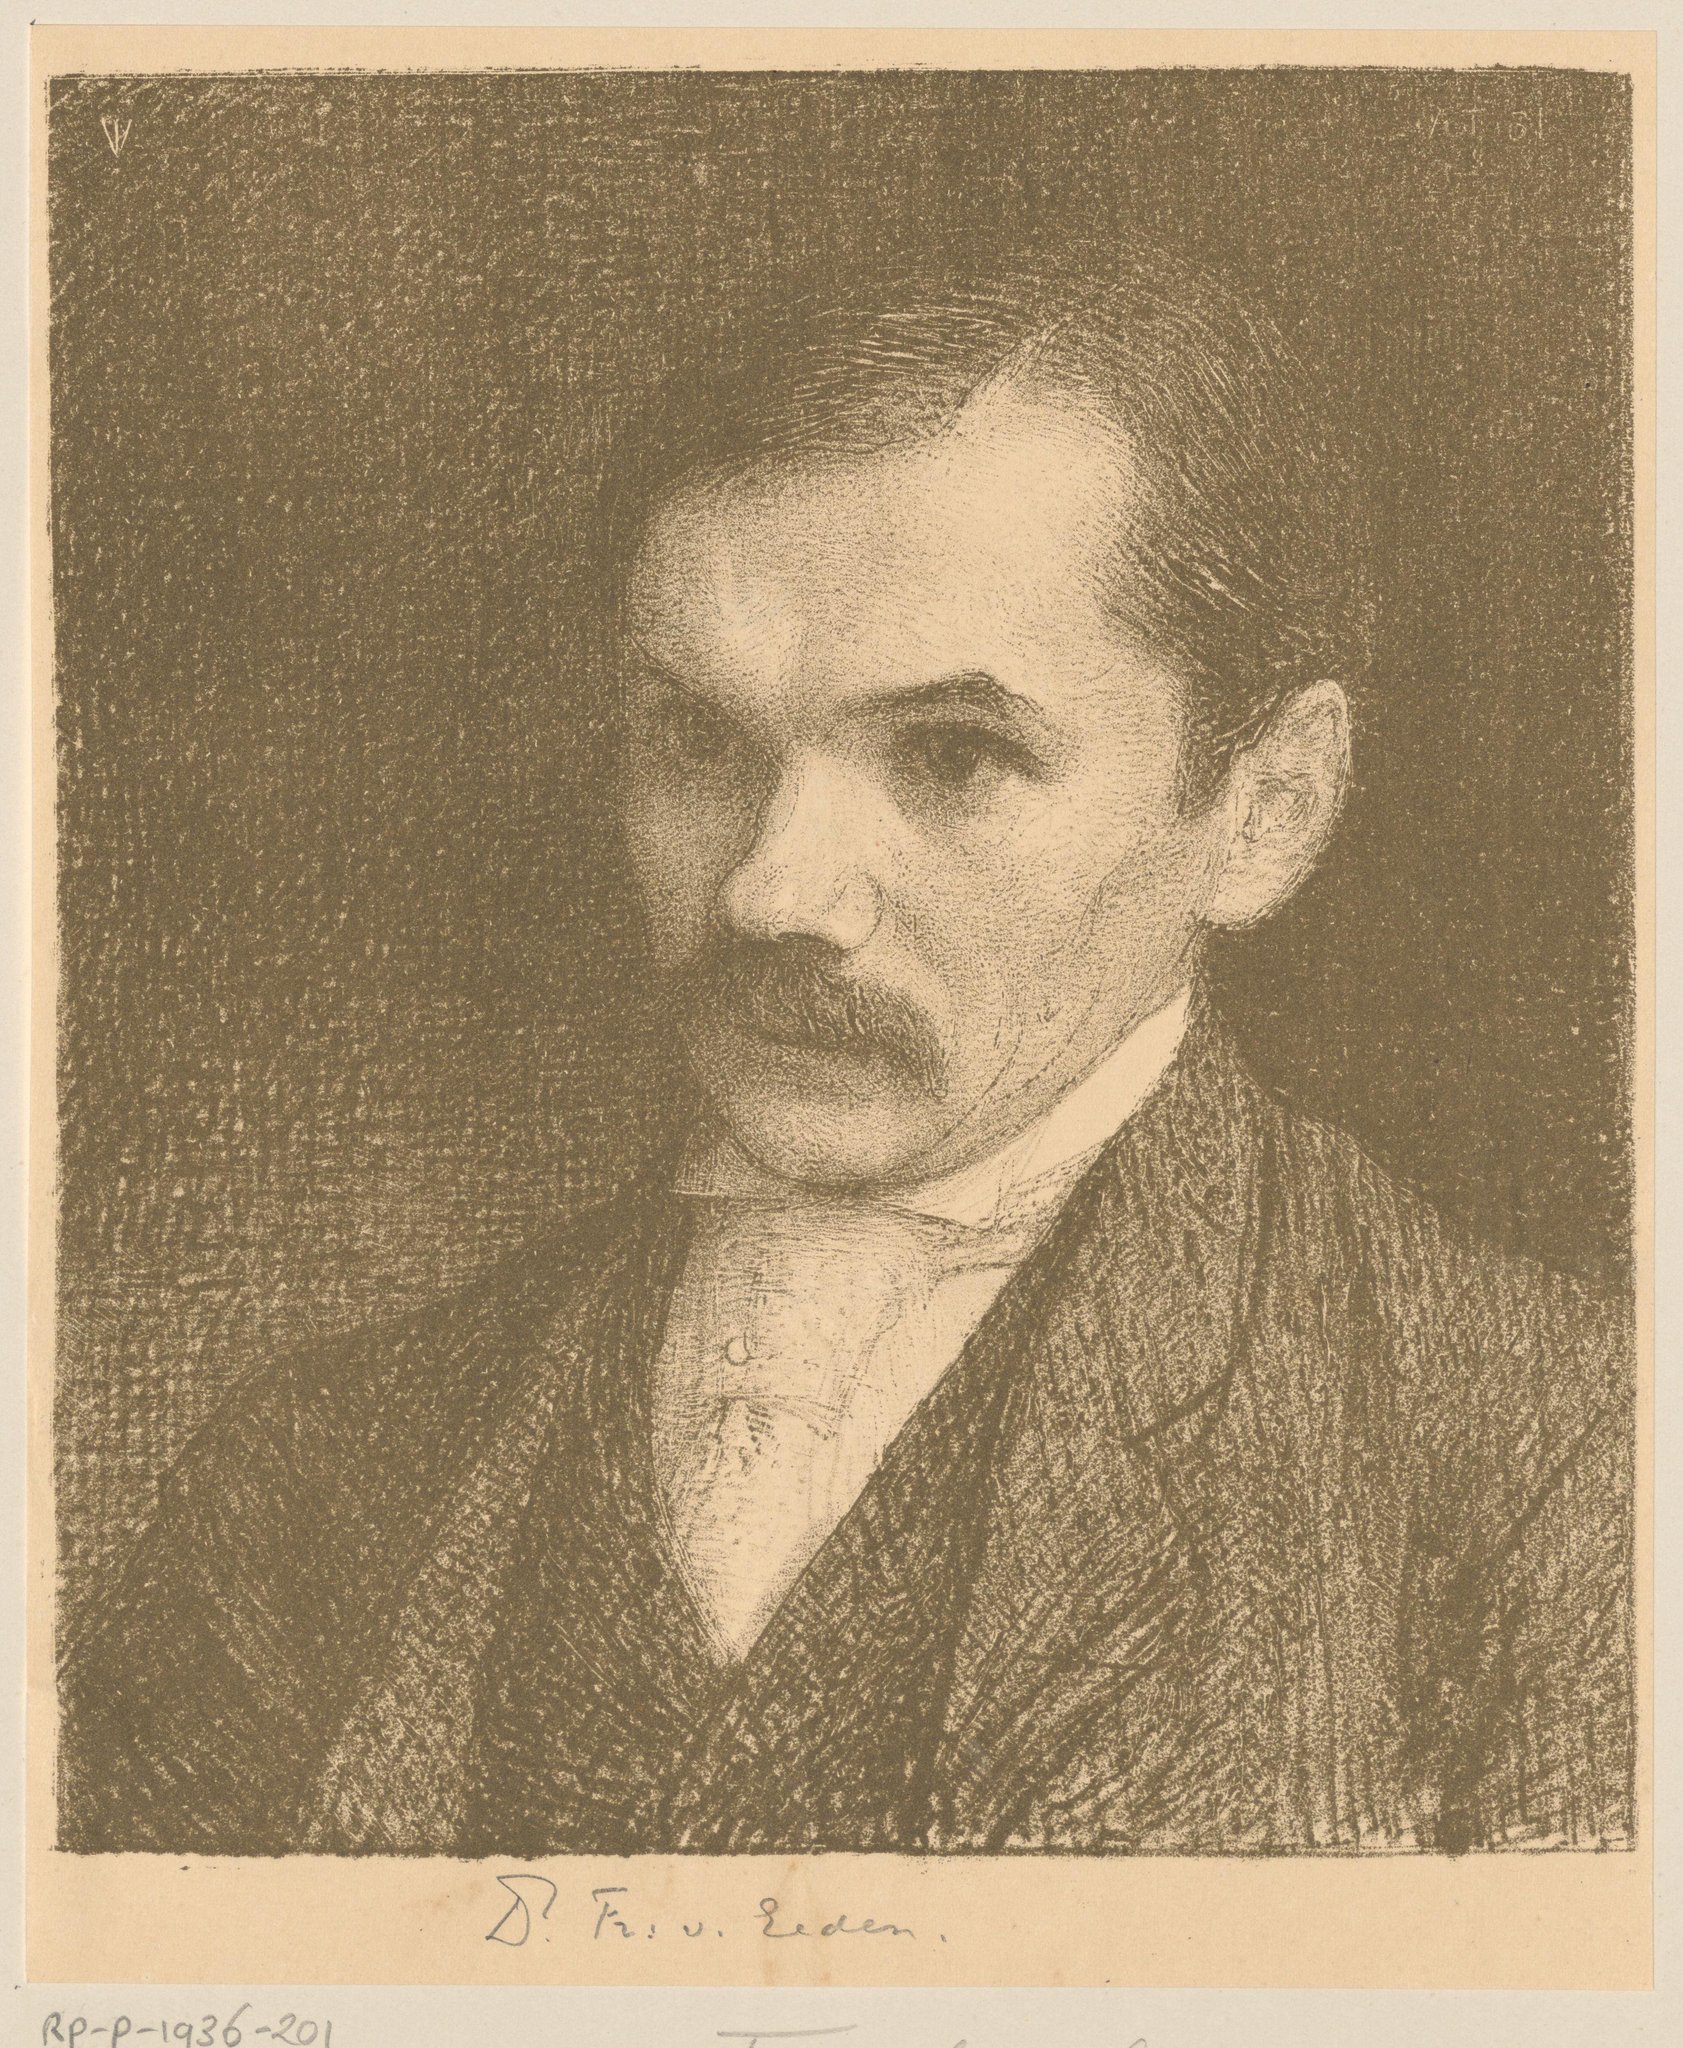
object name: print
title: Bekende tijdgenoten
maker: jan veth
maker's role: designer, draughtsman, painter, print maker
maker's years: 1864-1925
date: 1891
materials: paper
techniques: lithograph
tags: haarlem, frederik van eeden, historical persons, portrait of a writer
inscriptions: collector's mark: Lugt 2228